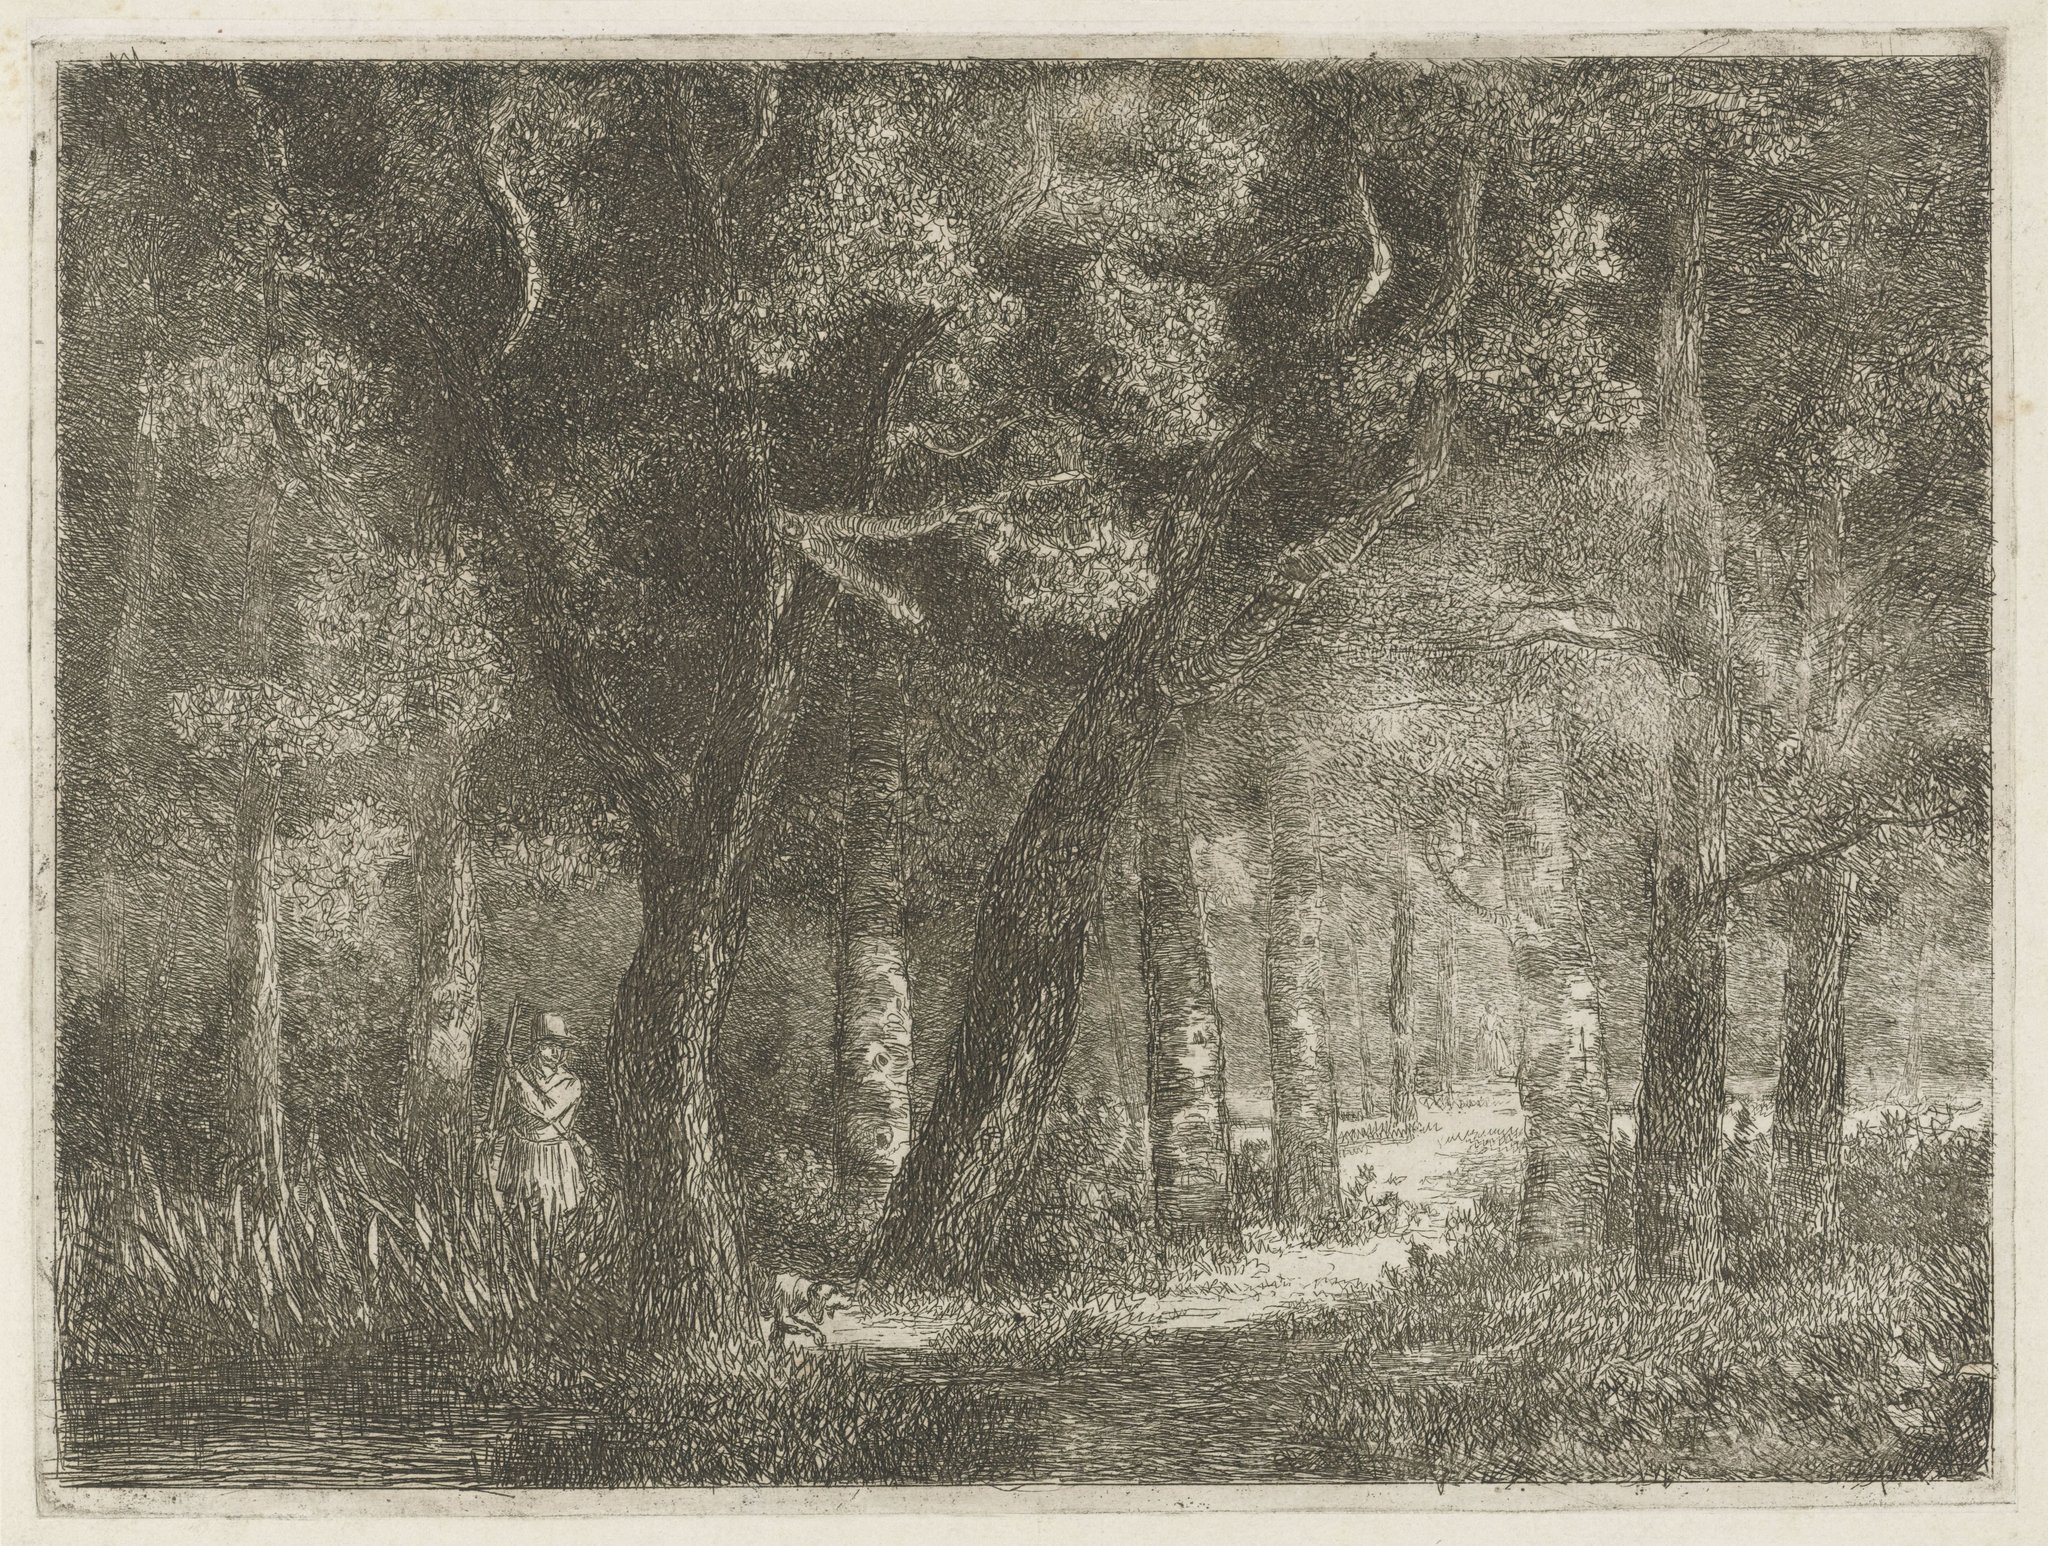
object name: print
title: Jager en zijn hond in het bos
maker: hermanus jan hendrik van rijkelijkhuysen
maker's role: painter, print maker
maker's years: 1813-1883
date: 1823-1883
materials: paper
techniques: drypoint, etching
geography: utrecht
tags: hunter, forest, wood, dog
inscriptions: collector's mark: Lugt 1485, collector's mark: Lugt 2228